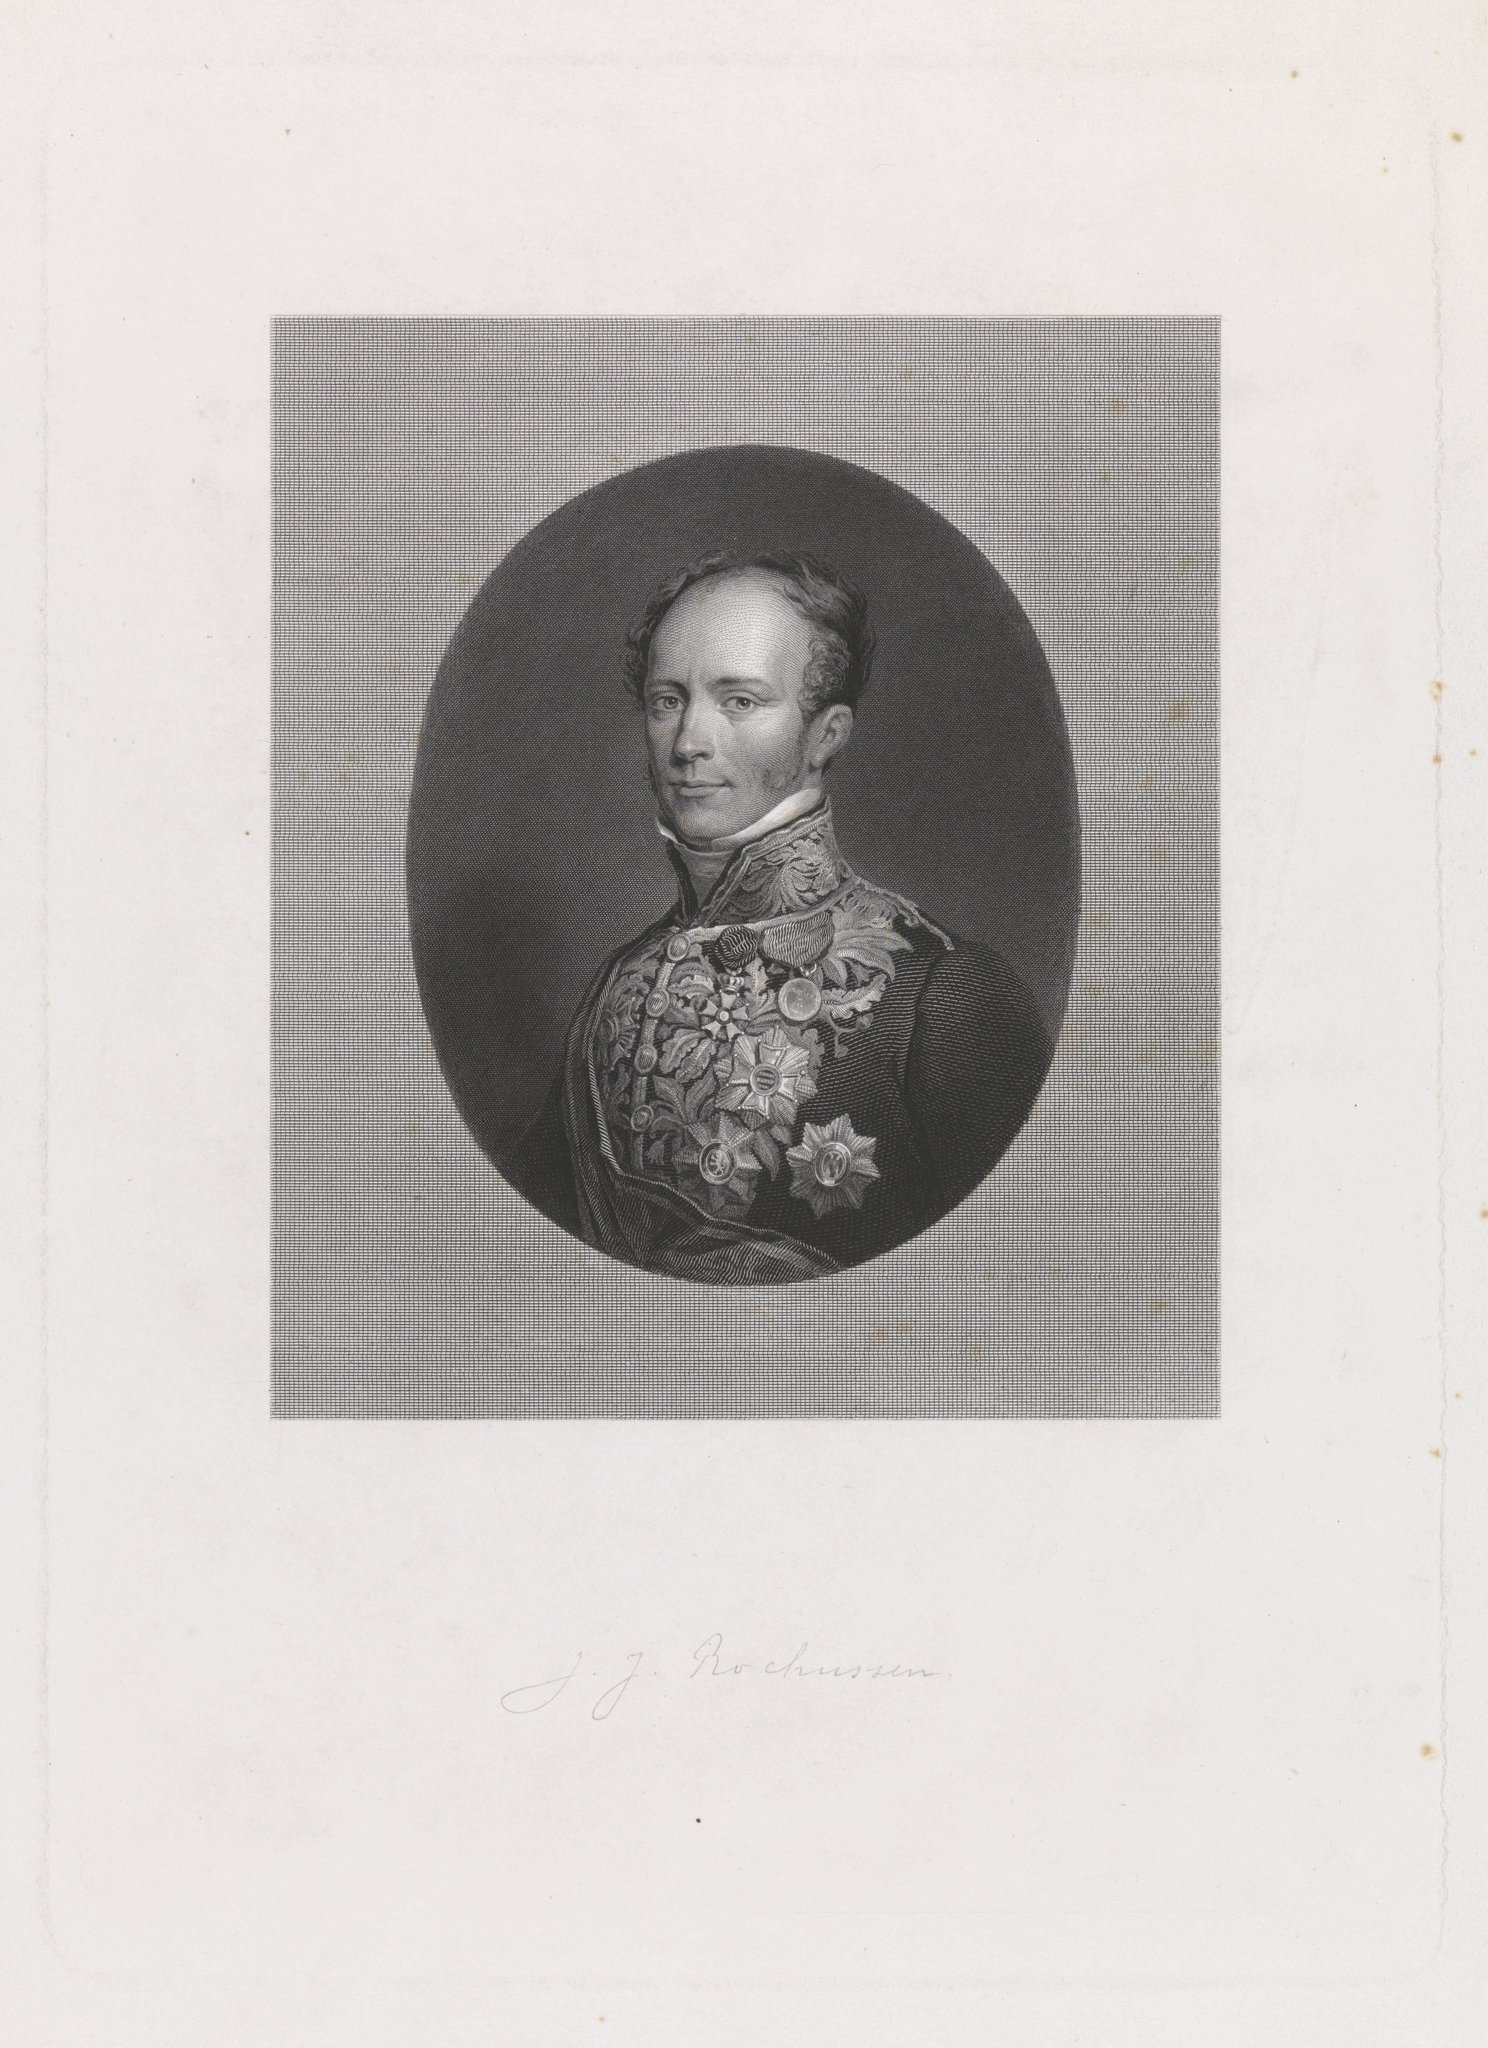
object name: print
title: Portret van Jan Jacob Rochussen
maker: johann wilhelm kaiser (i)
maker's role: draughtsman, print maker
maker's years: 1813-1900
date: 1823-1853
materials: paper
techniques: etching, roulette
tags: etten-leur, tweede kamerlid, gouverneur-generaal, minister van staat, minister van koloniën, jan jacob rochussen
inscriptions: inscription: ‘J.J. Rochussen’, collector's mark: Lugt 12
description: Portretbuste naar links van de politicus Jan Jacob Rochussen in galakleding.